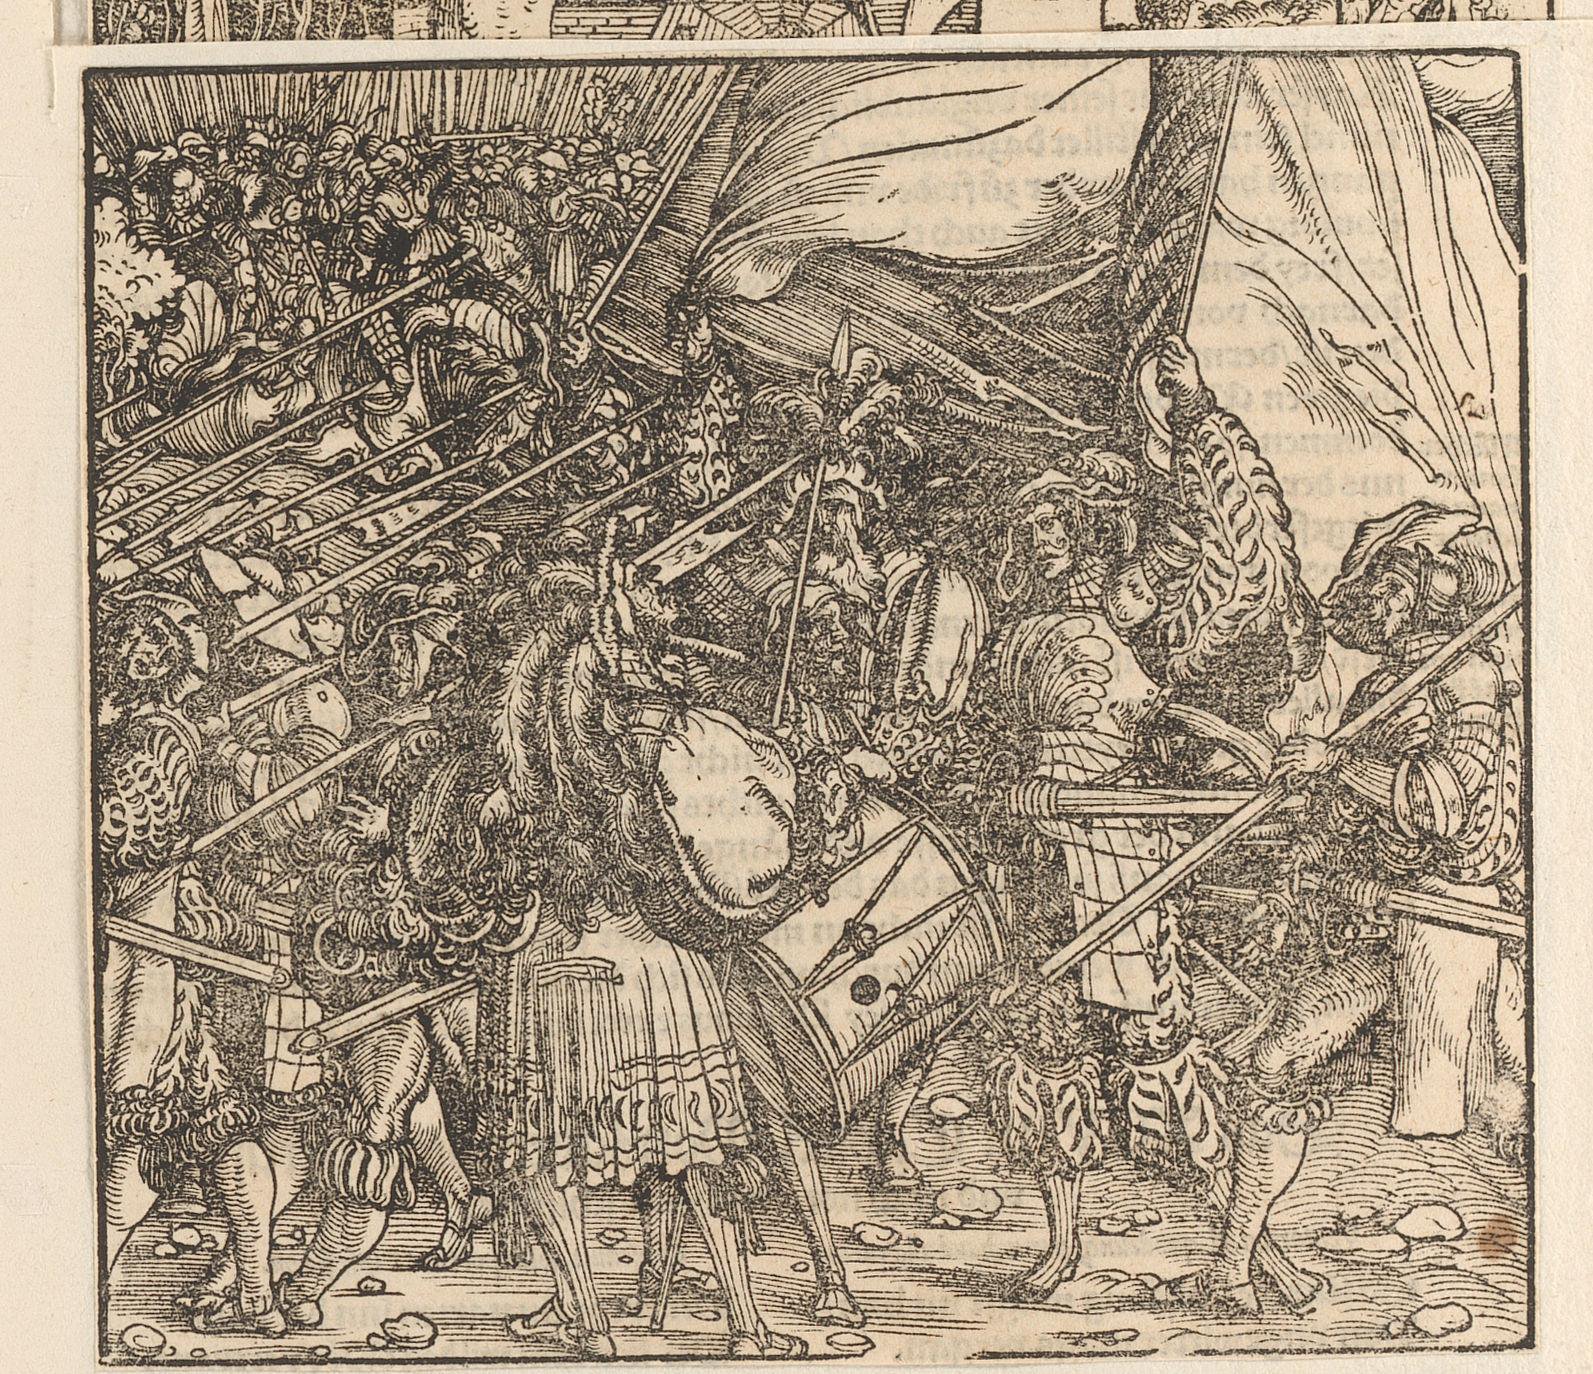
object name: album leaf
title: Stoet soldaten met lansen begeleid door muziek en vlaggendragers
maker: Anonymous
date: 1514-1532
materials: paper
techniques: letterpress printing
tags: army 'en route', flag display, drumming-up the public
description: Deze prent is gebruikt in: Petrarca, Francesco. Von der Artzney bayder Glück, des guten und widerwertigen: unnd weß sich ain yeder inn Gelück und Unglück halten sol (...). Augsburg: Heinrich Steiner, 1532. Deze uitgave is ook bekend onder de titel 'Trostspiegel in Glück und Unglück'.